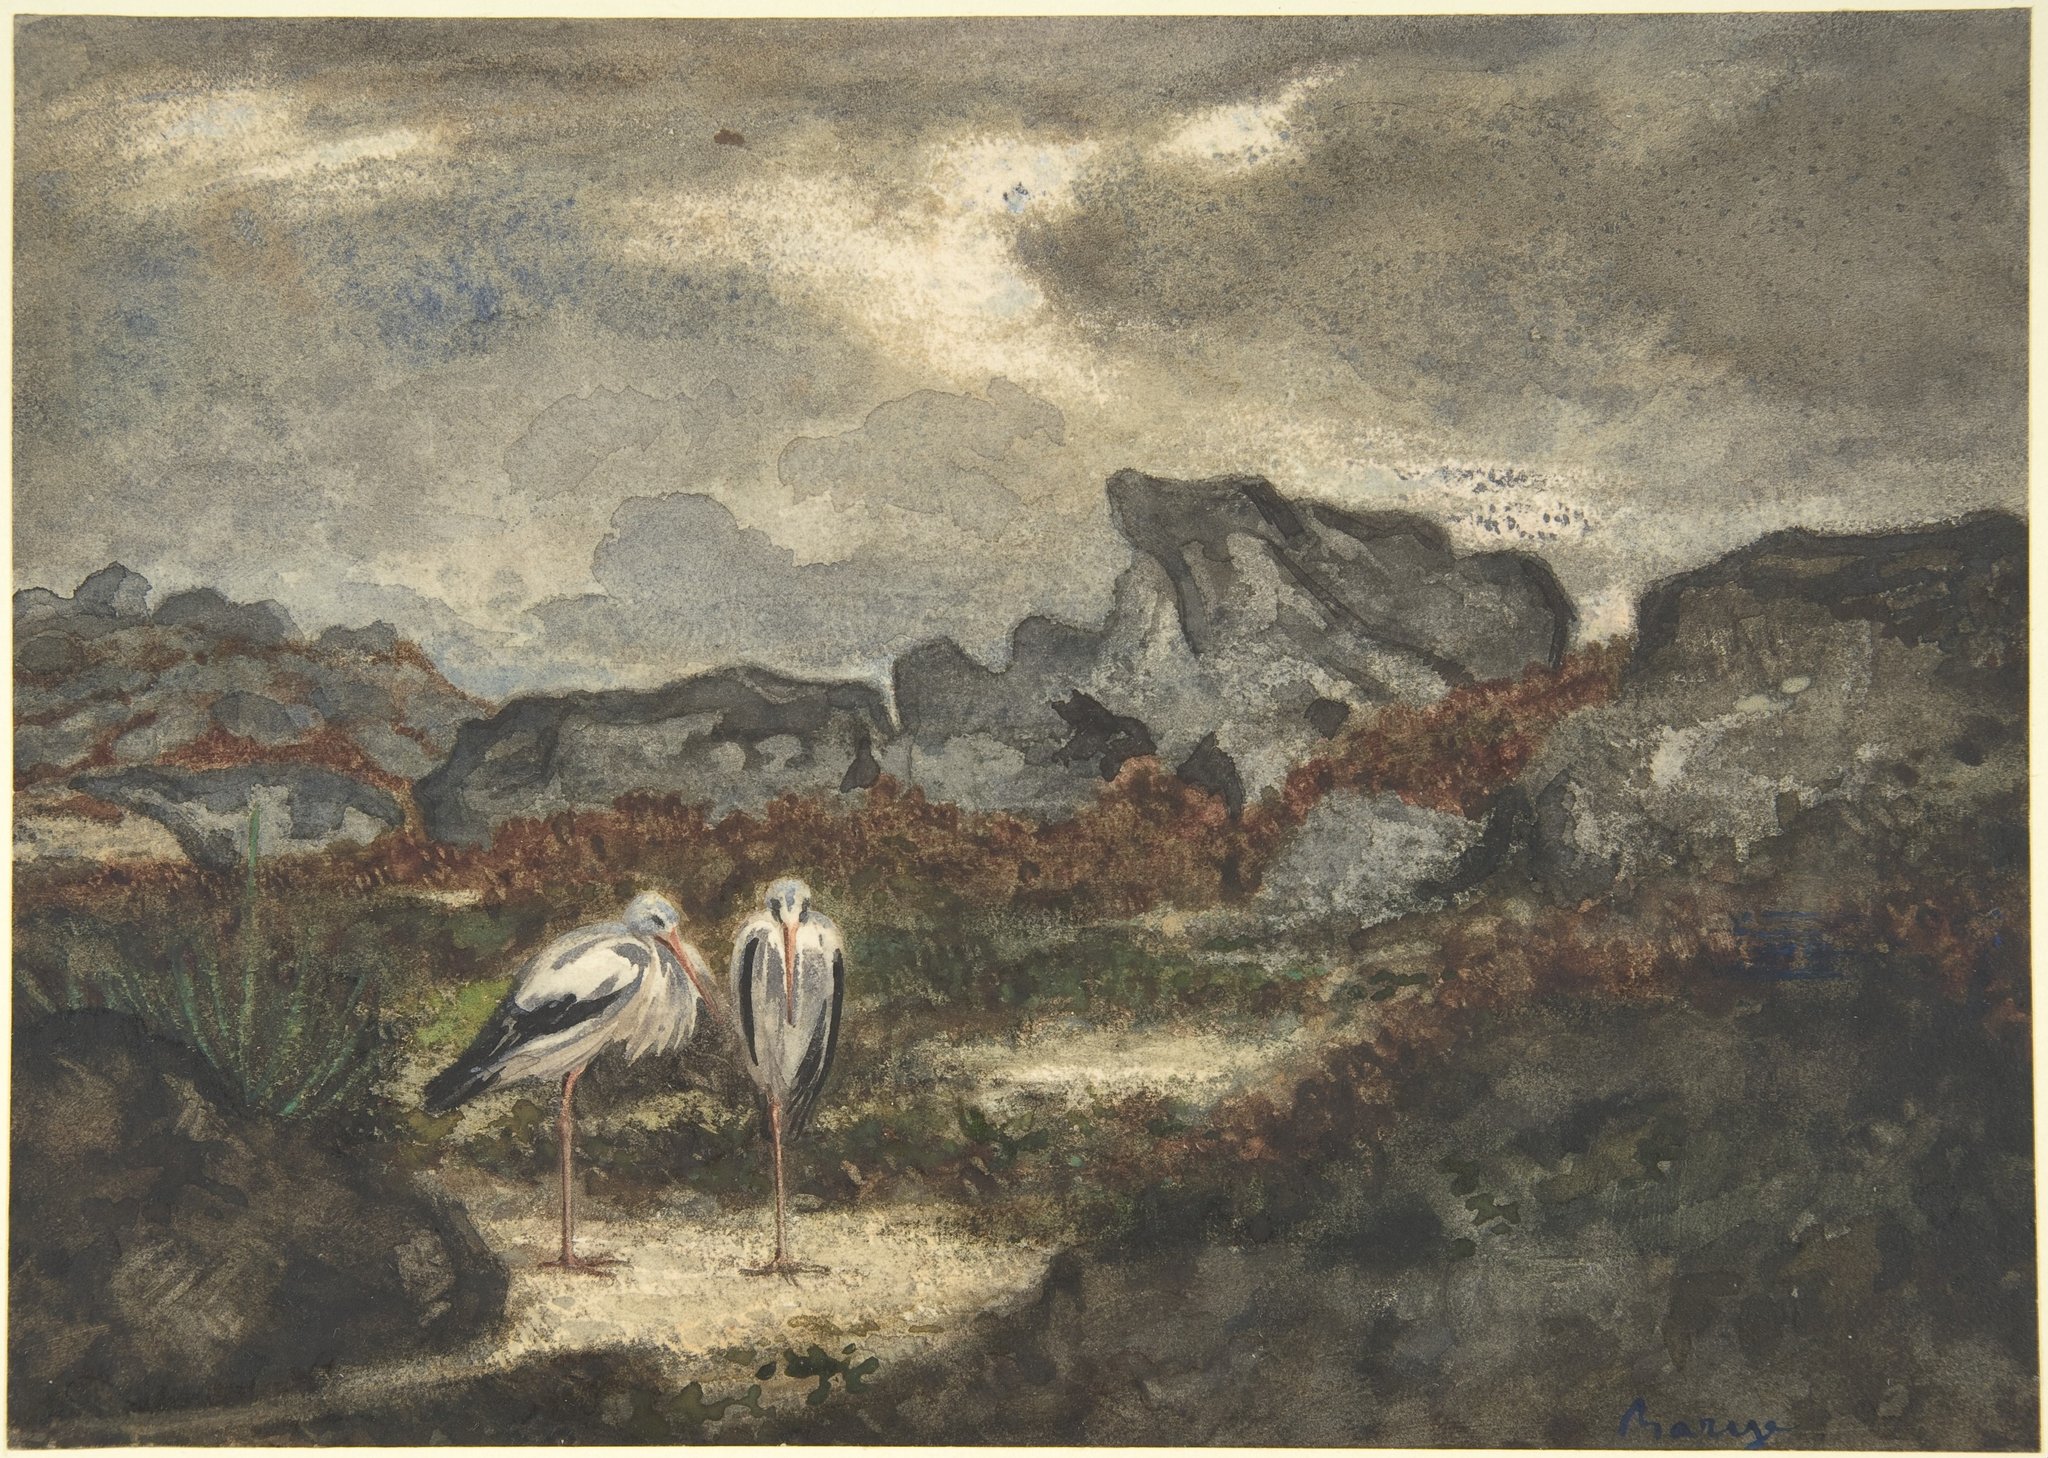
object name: drawing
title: Herons in Landscape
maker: antoine-louis barye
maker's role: artist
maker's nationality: french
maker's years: 1795-1875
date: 1810-1875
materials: watercolor, paper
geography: france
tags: birds,landscapes